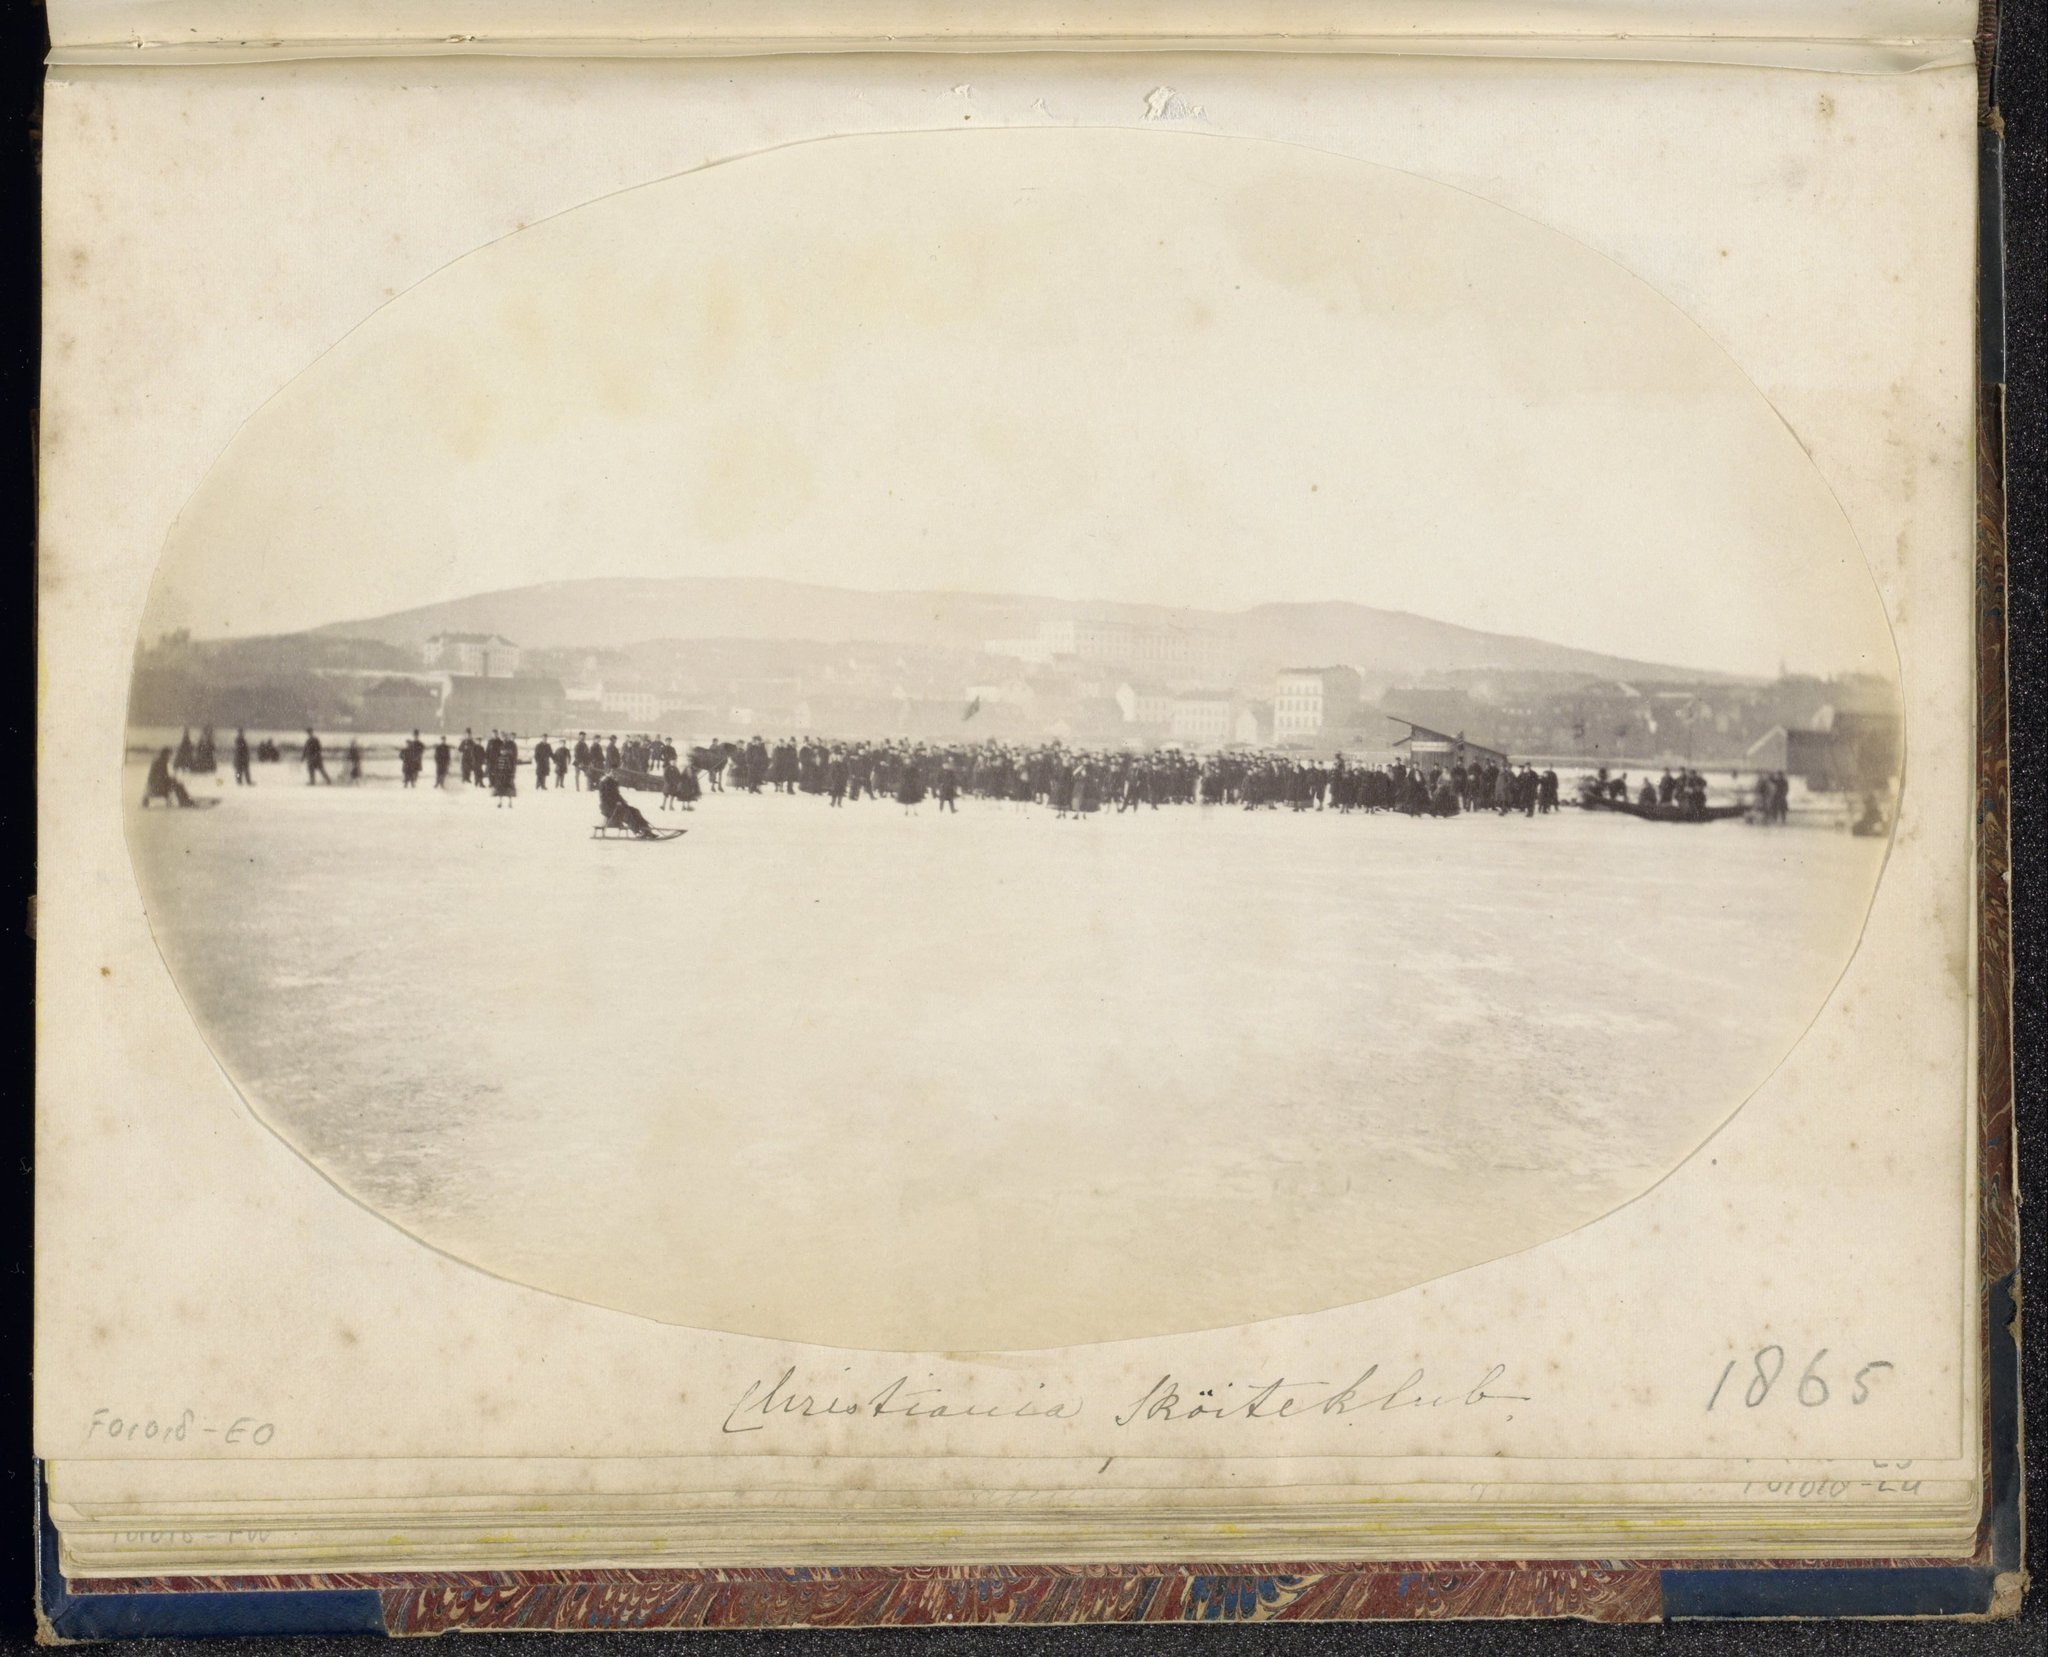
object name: photograph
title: Christiania Sköiteklub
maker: Anonymous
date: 1865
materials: paper, photographic support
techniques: albumen print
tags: prospect of village, silhouette of village, skates (winter sports)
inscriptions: date: ‘1865’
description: Onderdeel van Engels familiealbum met foto's van personen, reizen, cricket en kunstwerken.